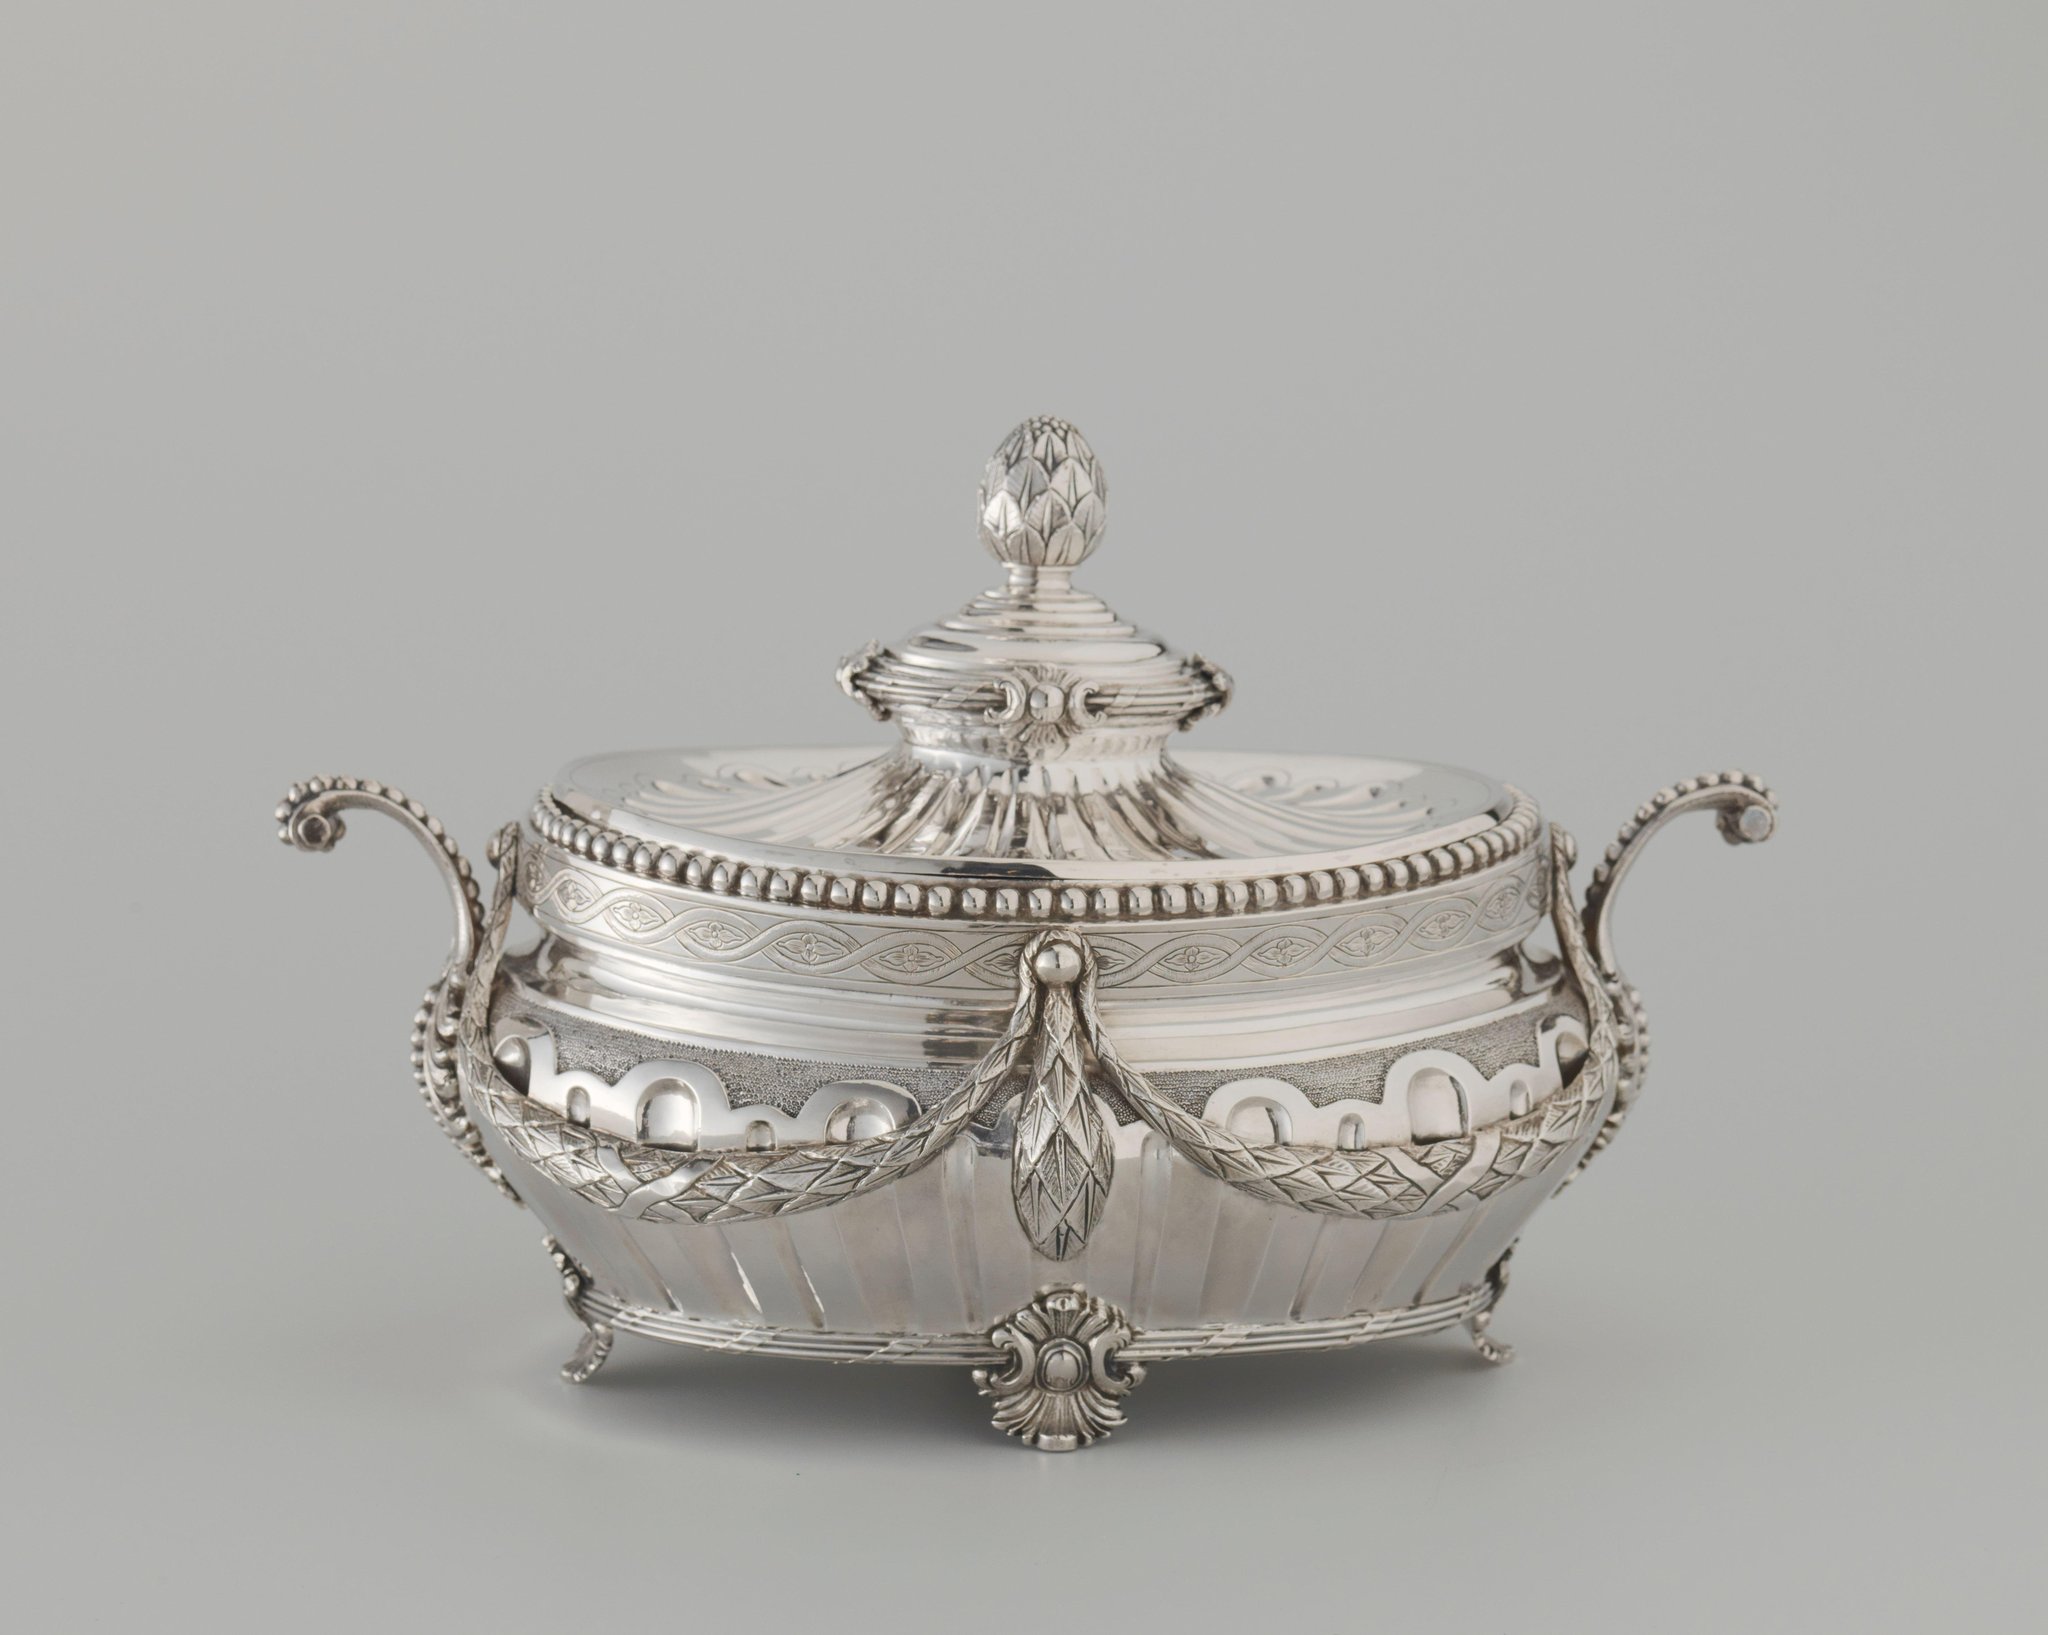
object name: lid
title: Een deksel van kleine ovale terrine in Lodewijk XVI-stijl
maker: philippus priee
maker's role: silversmith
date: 1773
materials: silver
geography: middelburg